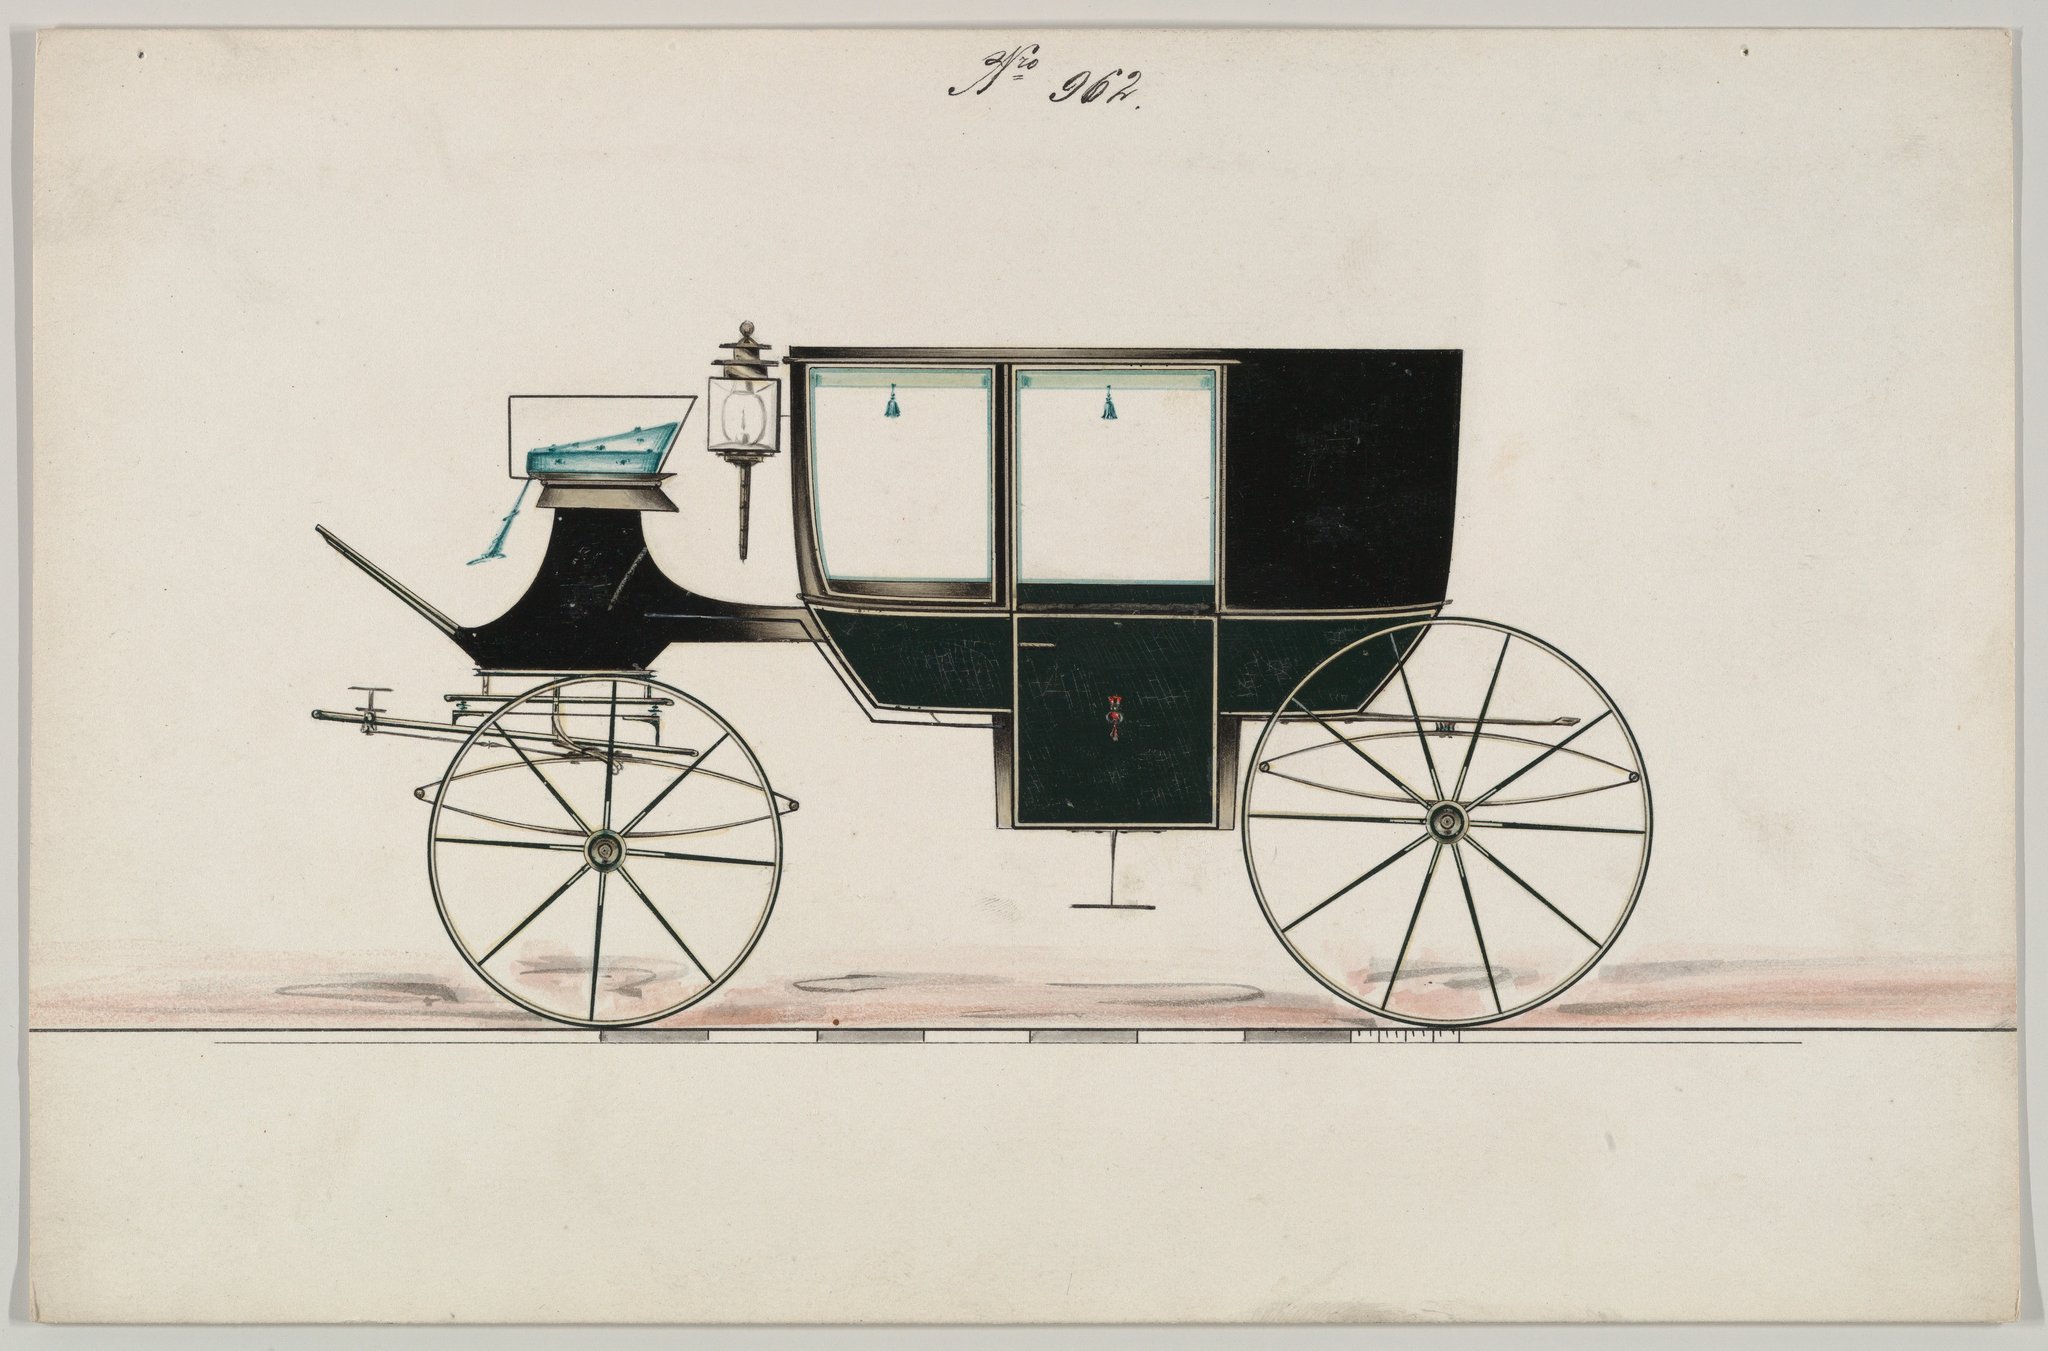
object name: drawing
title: Coach #962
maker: brewster & co.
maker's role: manufacturer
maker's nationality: american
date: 1870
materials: gum arabic, ink, watercolor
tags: carriages